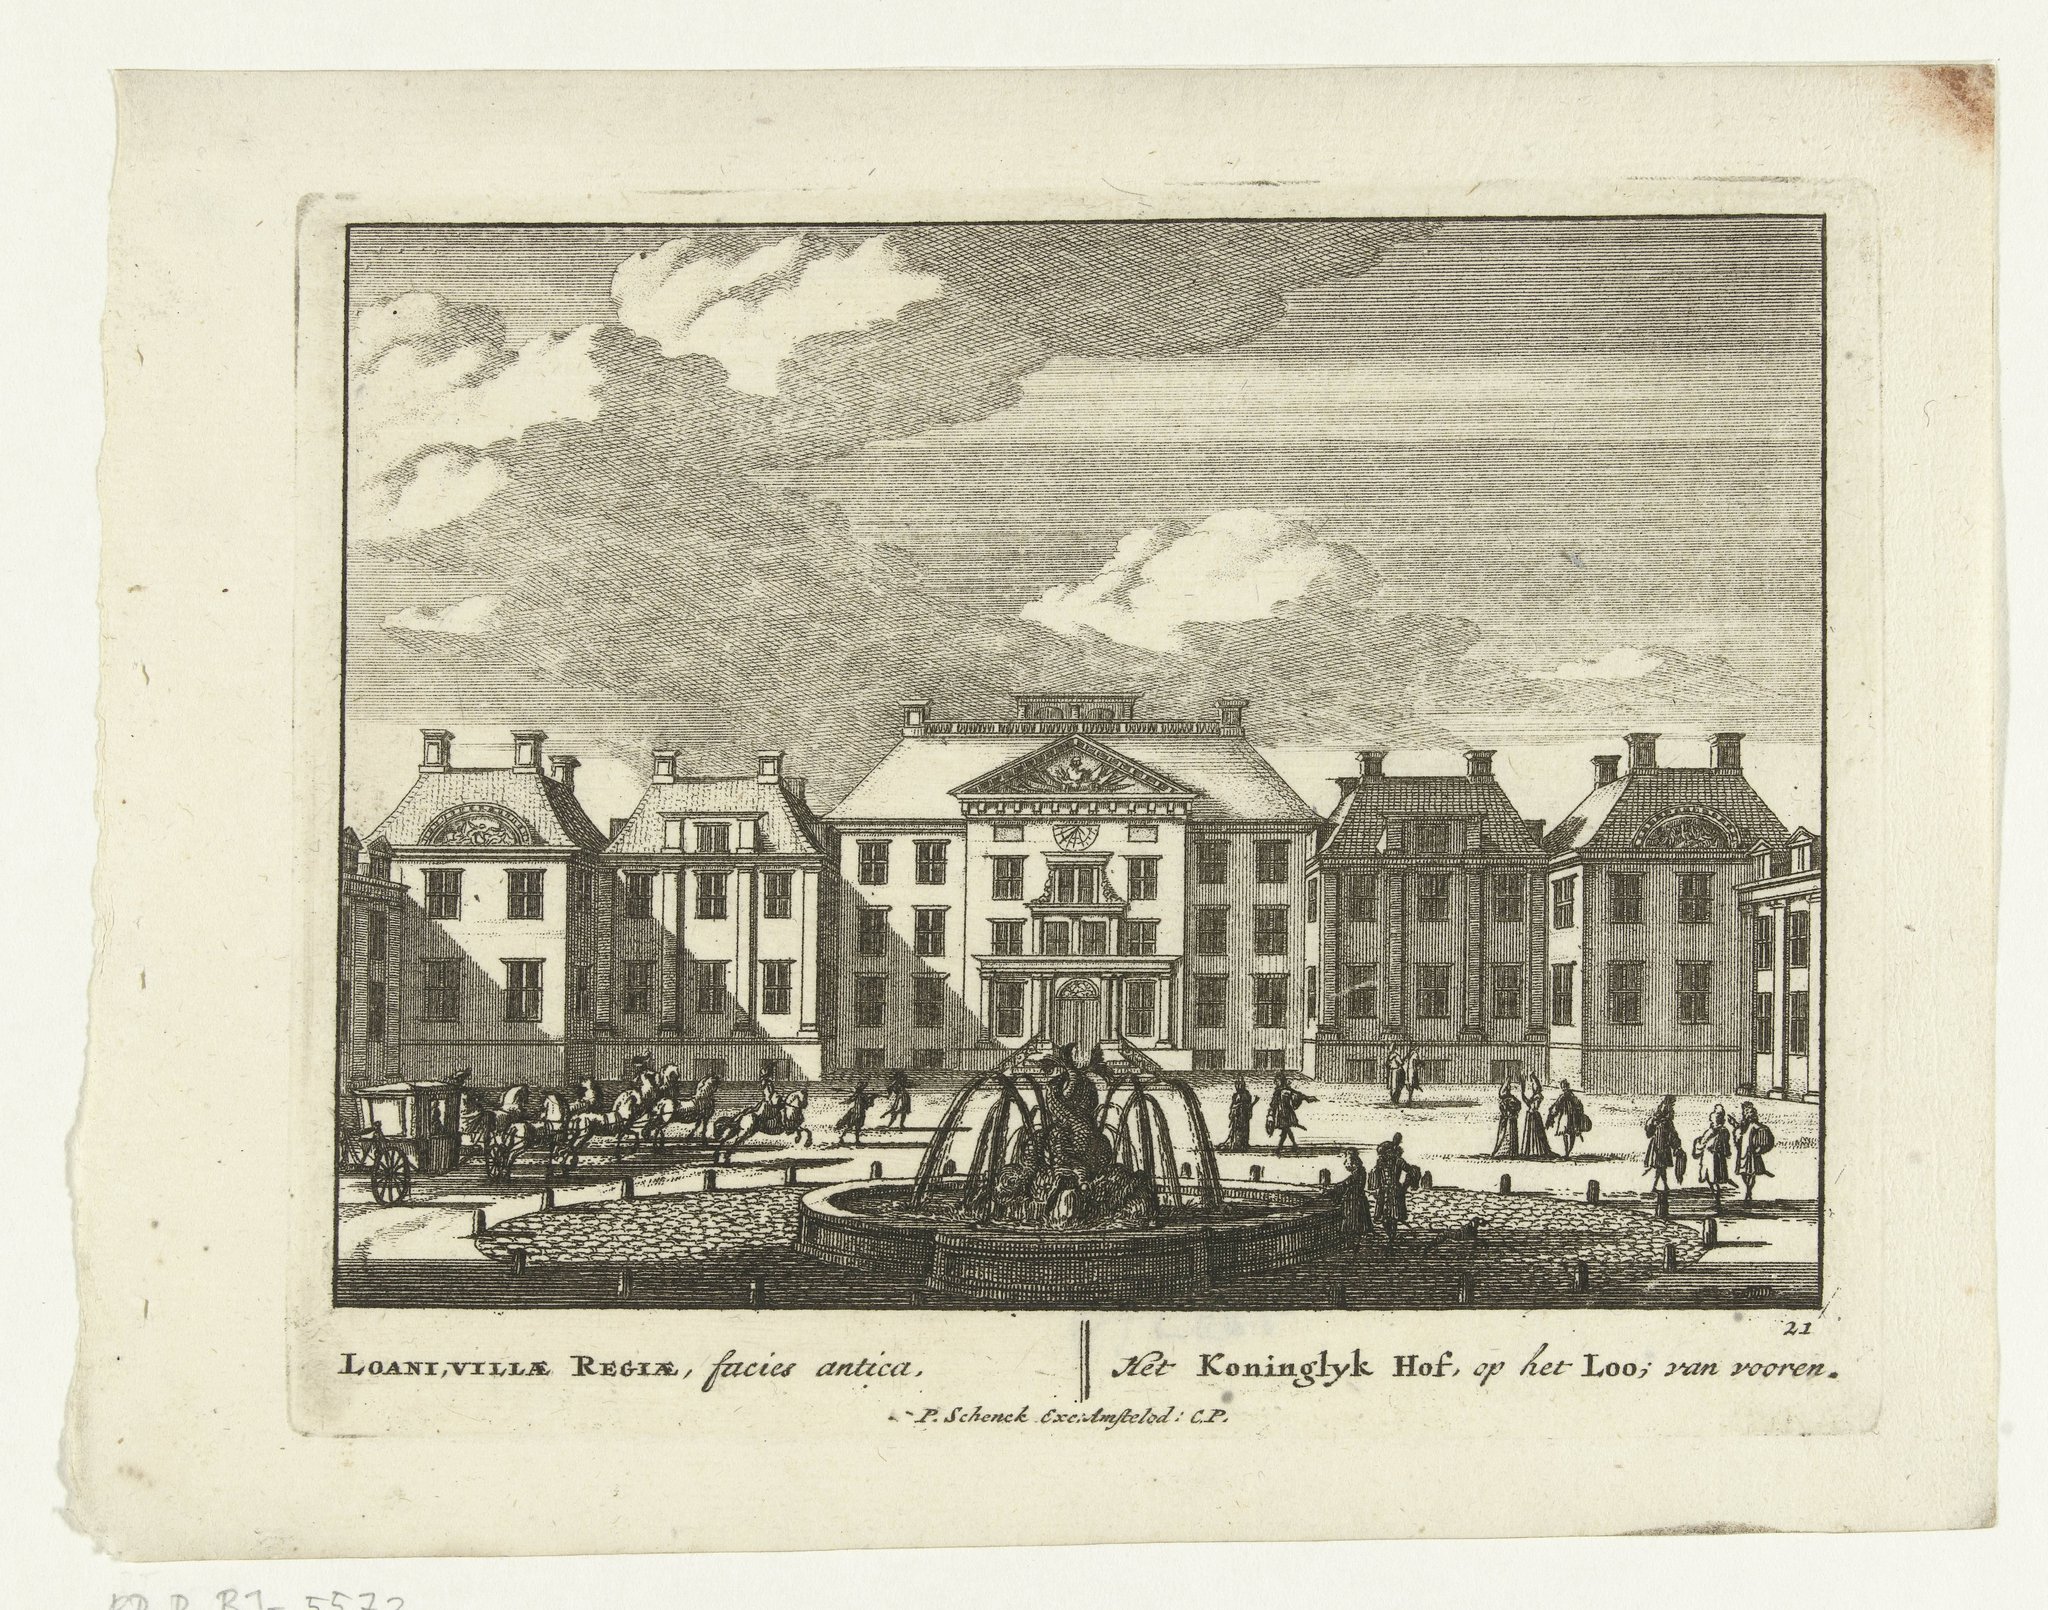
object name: print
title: Admirandorum quadruplex spectaculum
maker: pieter schenk (i)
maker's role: print maker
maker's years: 1660-1711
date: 1695-1705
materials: paper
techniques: etching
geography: amsterdam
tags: french or architectonic garden; formal garden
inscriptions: collector's mark: Lugt 2228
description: Prent uit een serie van 71 prenten met Rijnlandschappen, gezichten op vorstelijke paleizen en stadsgezichten uit Den Haag en Amsterdam.